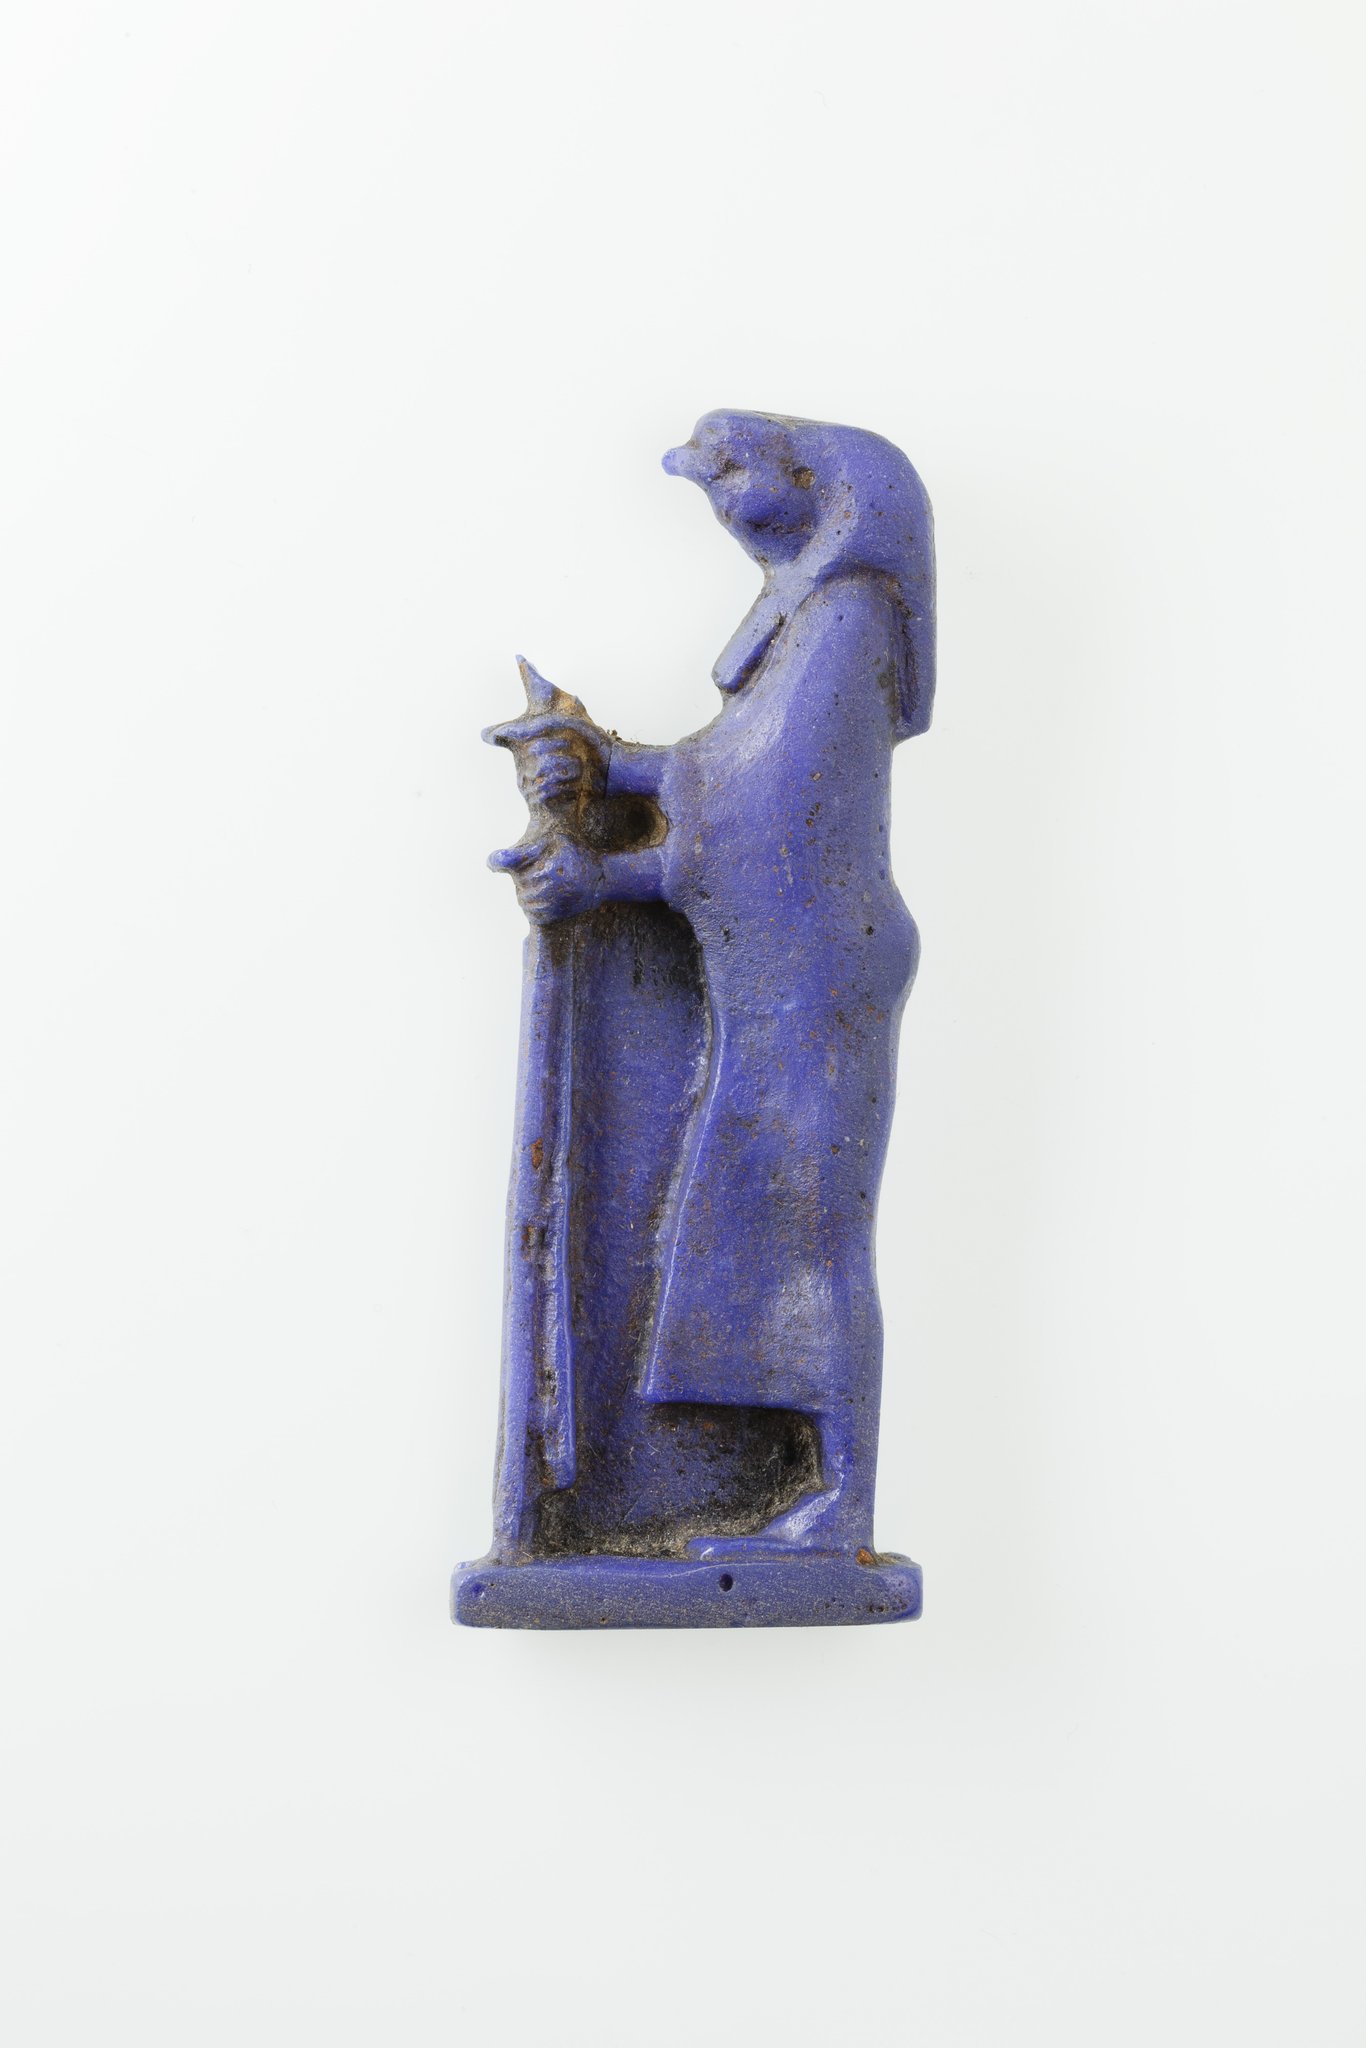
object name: amulet, four son of horus, qebehsenuef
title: Funerary amulet depicting one of the Four Sons of Horus, Qebehsenuef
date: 332-330 BCE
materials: glass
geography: egypt